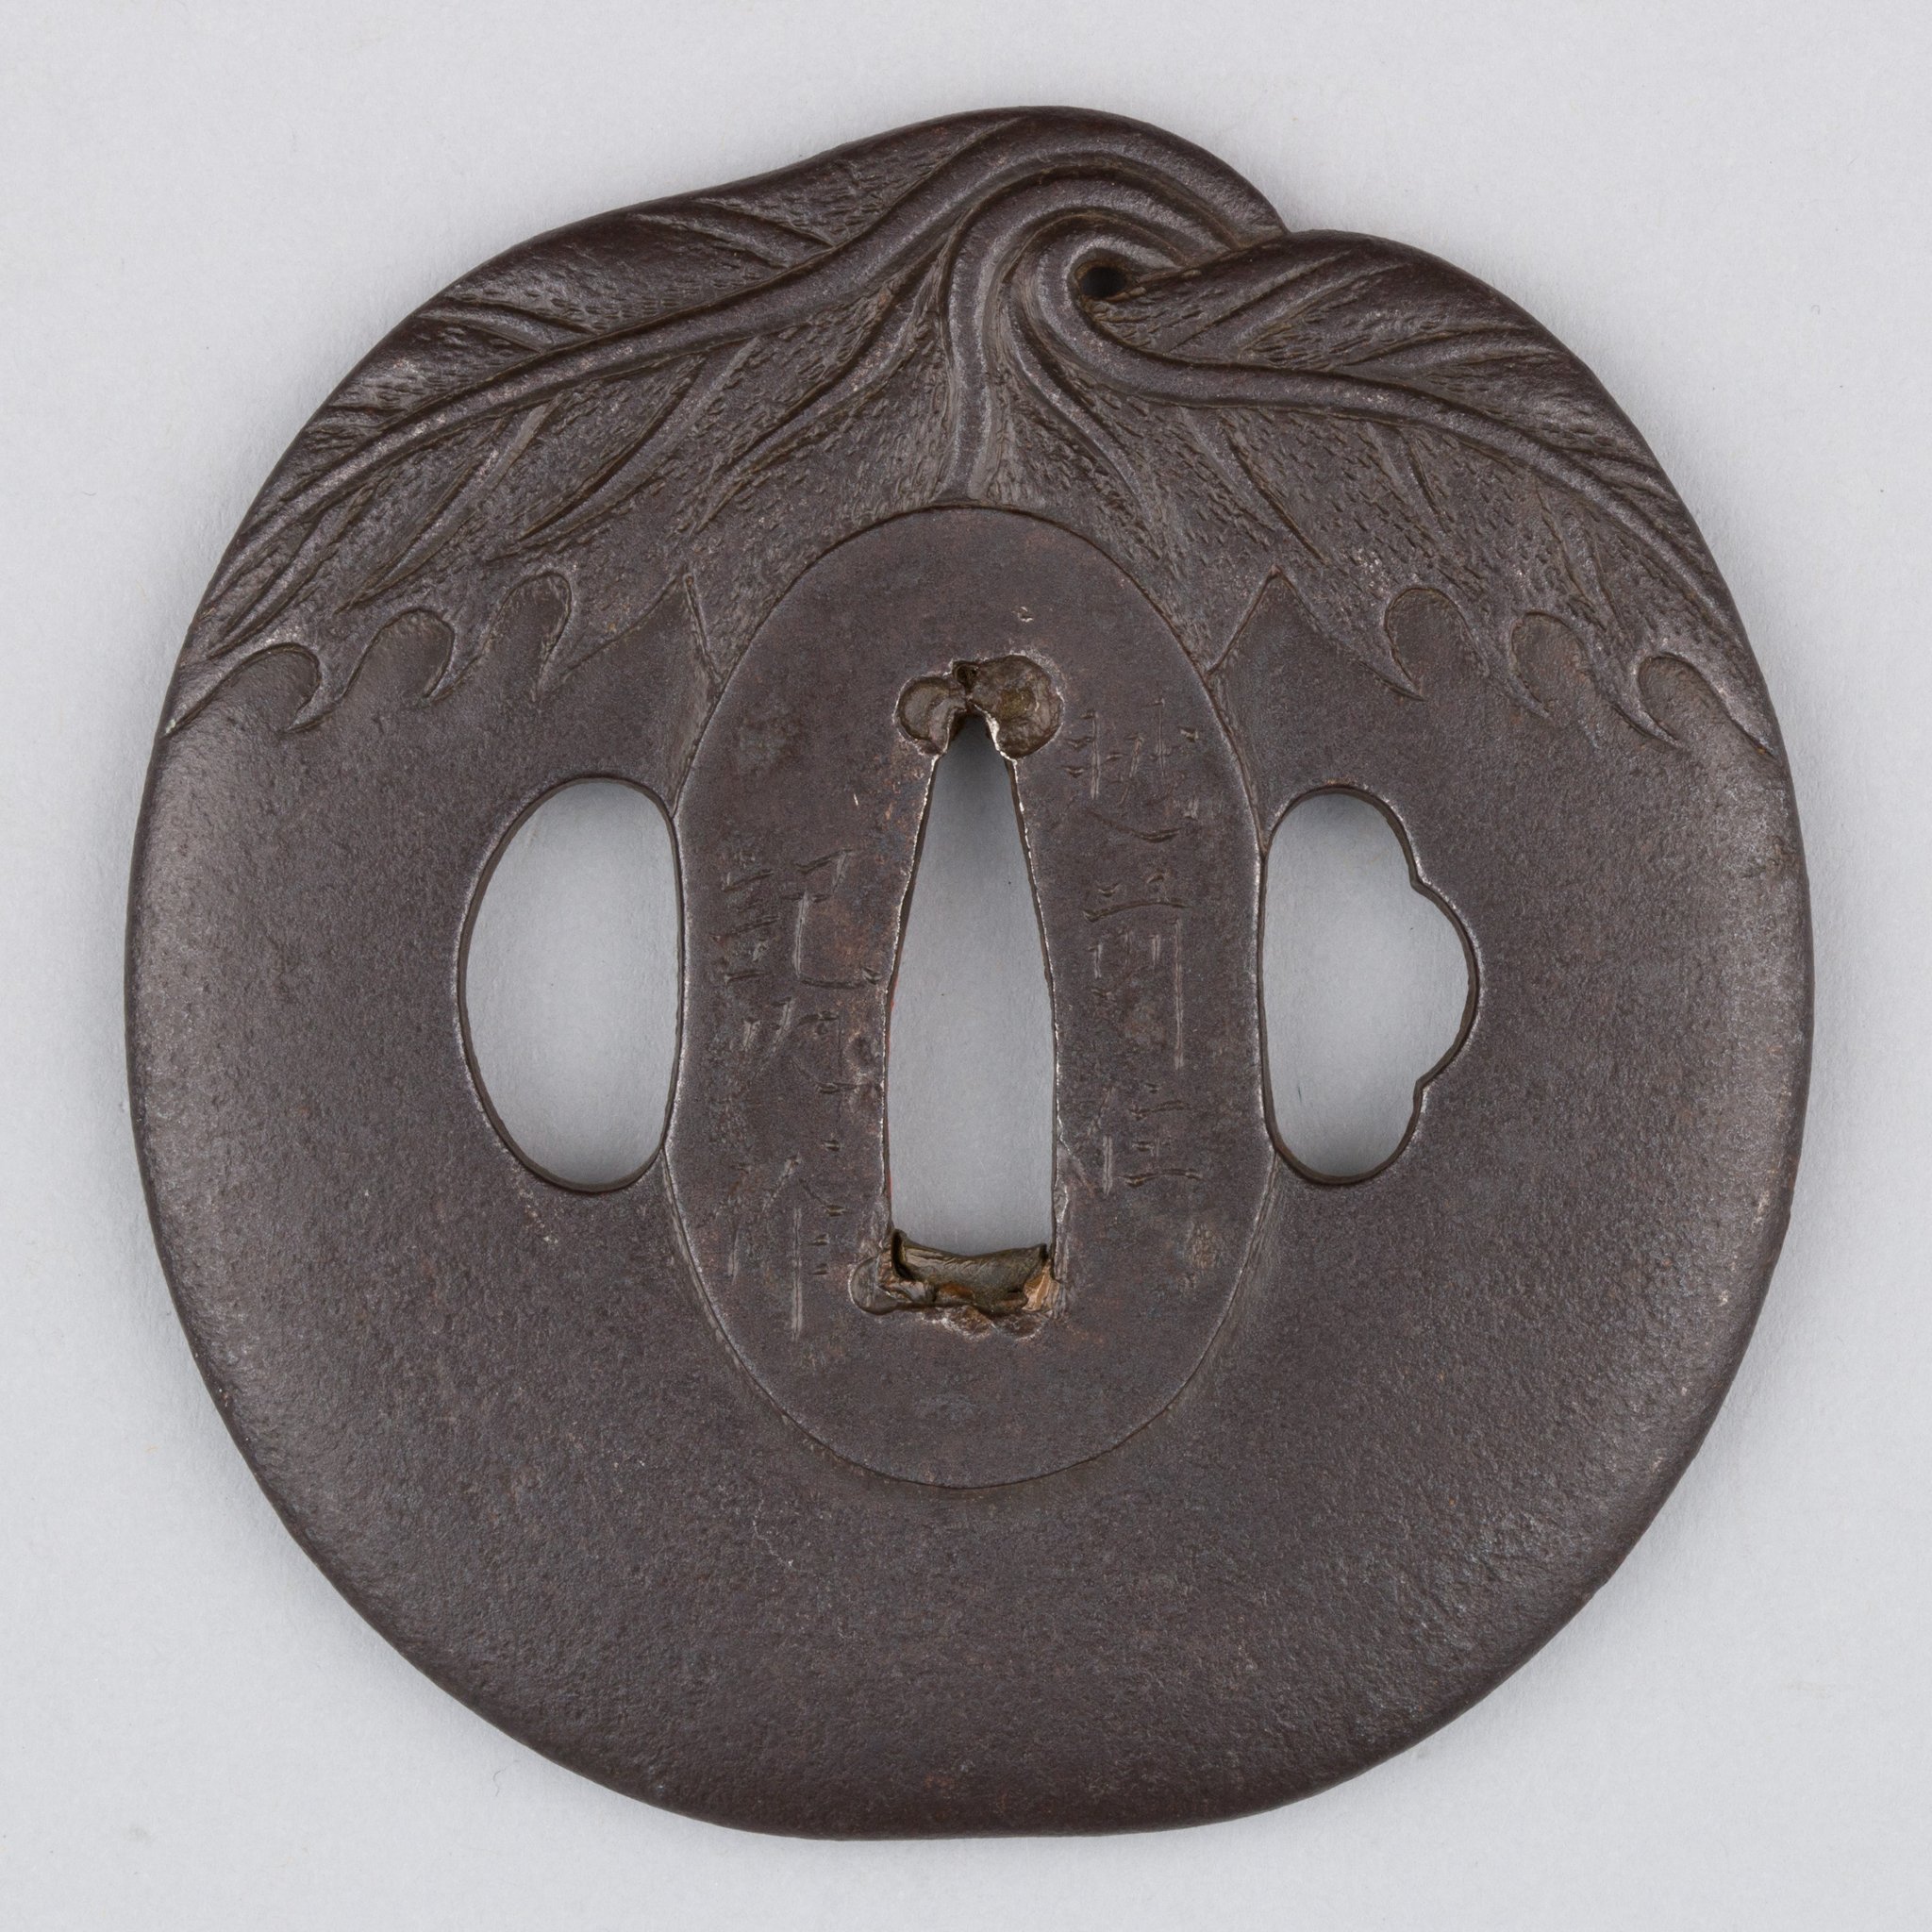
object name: sword guard tsuba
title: Sword Guard (Tsuba)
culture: japanese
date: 1701-1800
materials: copper, iron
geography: japan